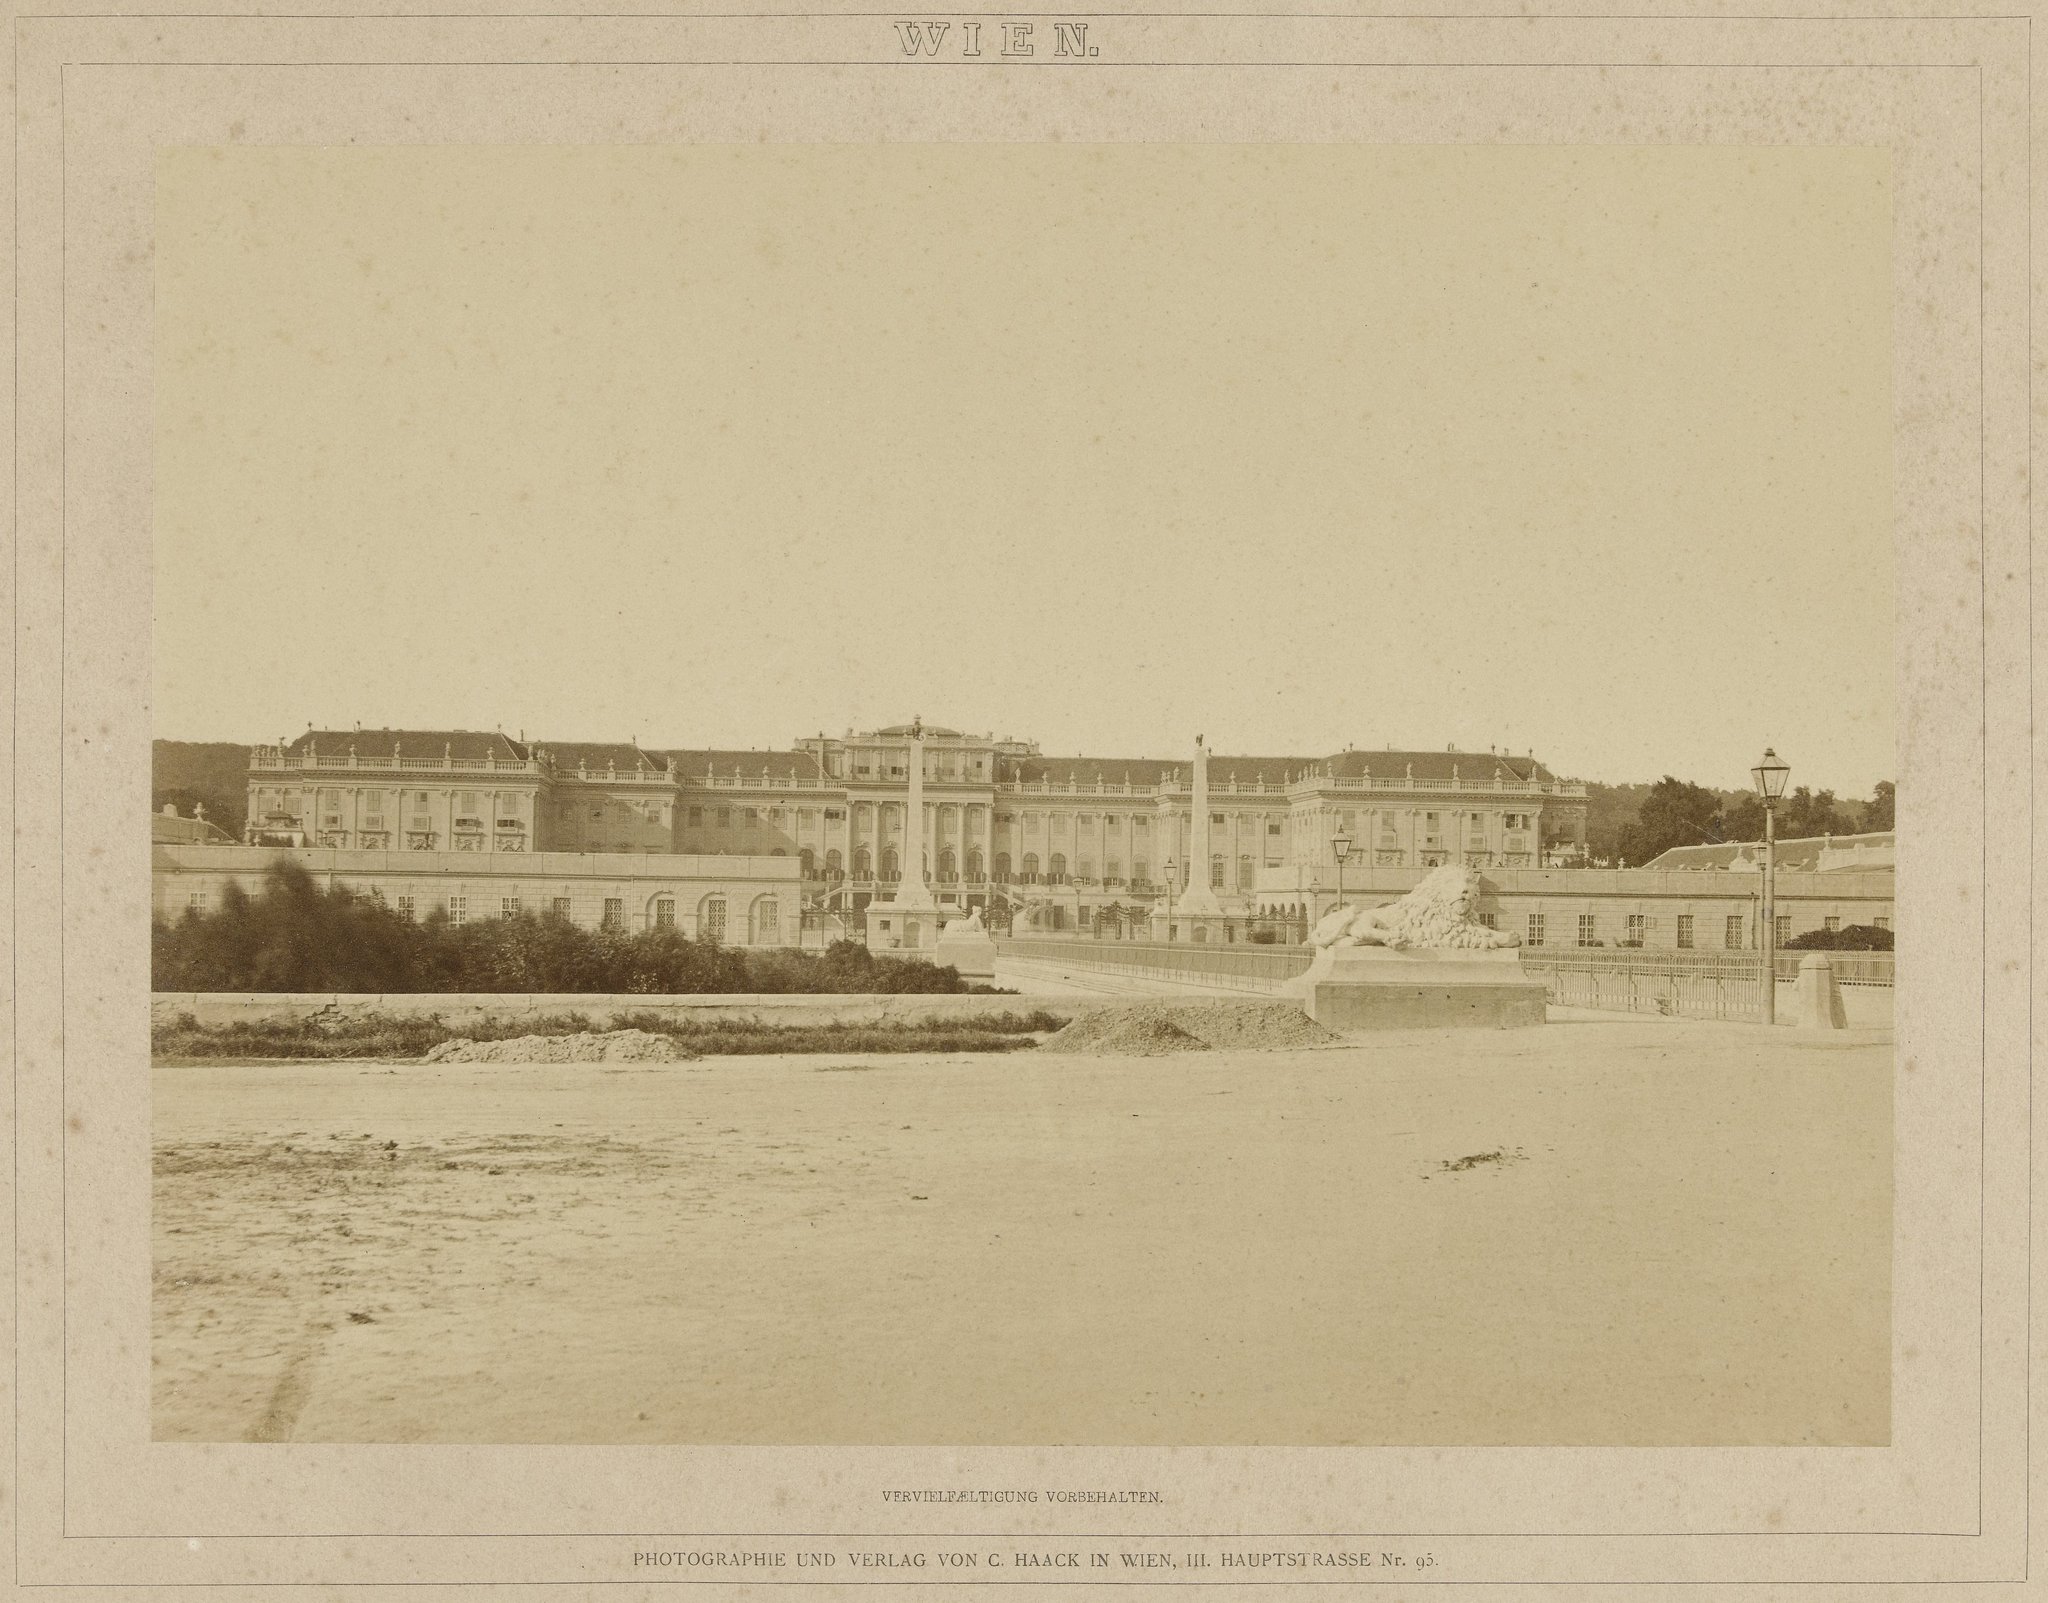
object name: photograph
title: Wien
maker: carl haack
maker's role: fotograaf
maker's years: 1842-1908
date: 1880-1900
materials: cardboard, paper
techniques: albumen print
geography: vienna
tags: palace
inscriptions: inscription: ‘83. Wien-K.k. Sommer Residenz Schönbrunn’, inscription: ‘VERVIELFAELTIGUNG VORBEHALTEN.’, inscription: ‘Schönbrunn’, address: ‘PHOTOGAPHIE UND VERLAG VON C. HAACK IN WIEN, III. HAUPTSTRASSE Nr. 95.’